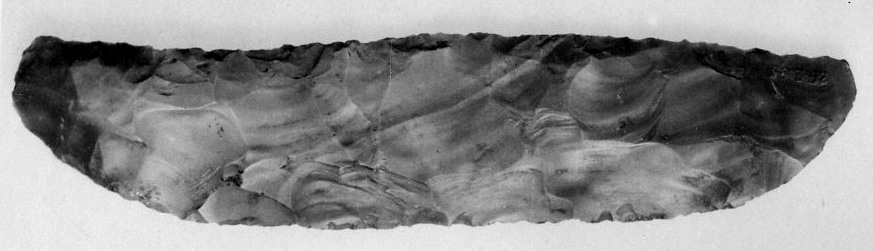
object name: knife, bifacial knife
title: Bifacial Knife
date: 3850-2960 BCE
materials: stone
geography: egypt